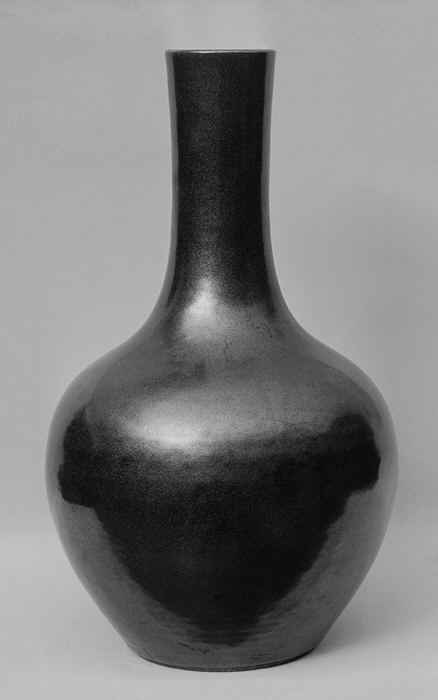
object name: bottle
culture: chinese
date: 1736-1795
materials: glaze, porcelain